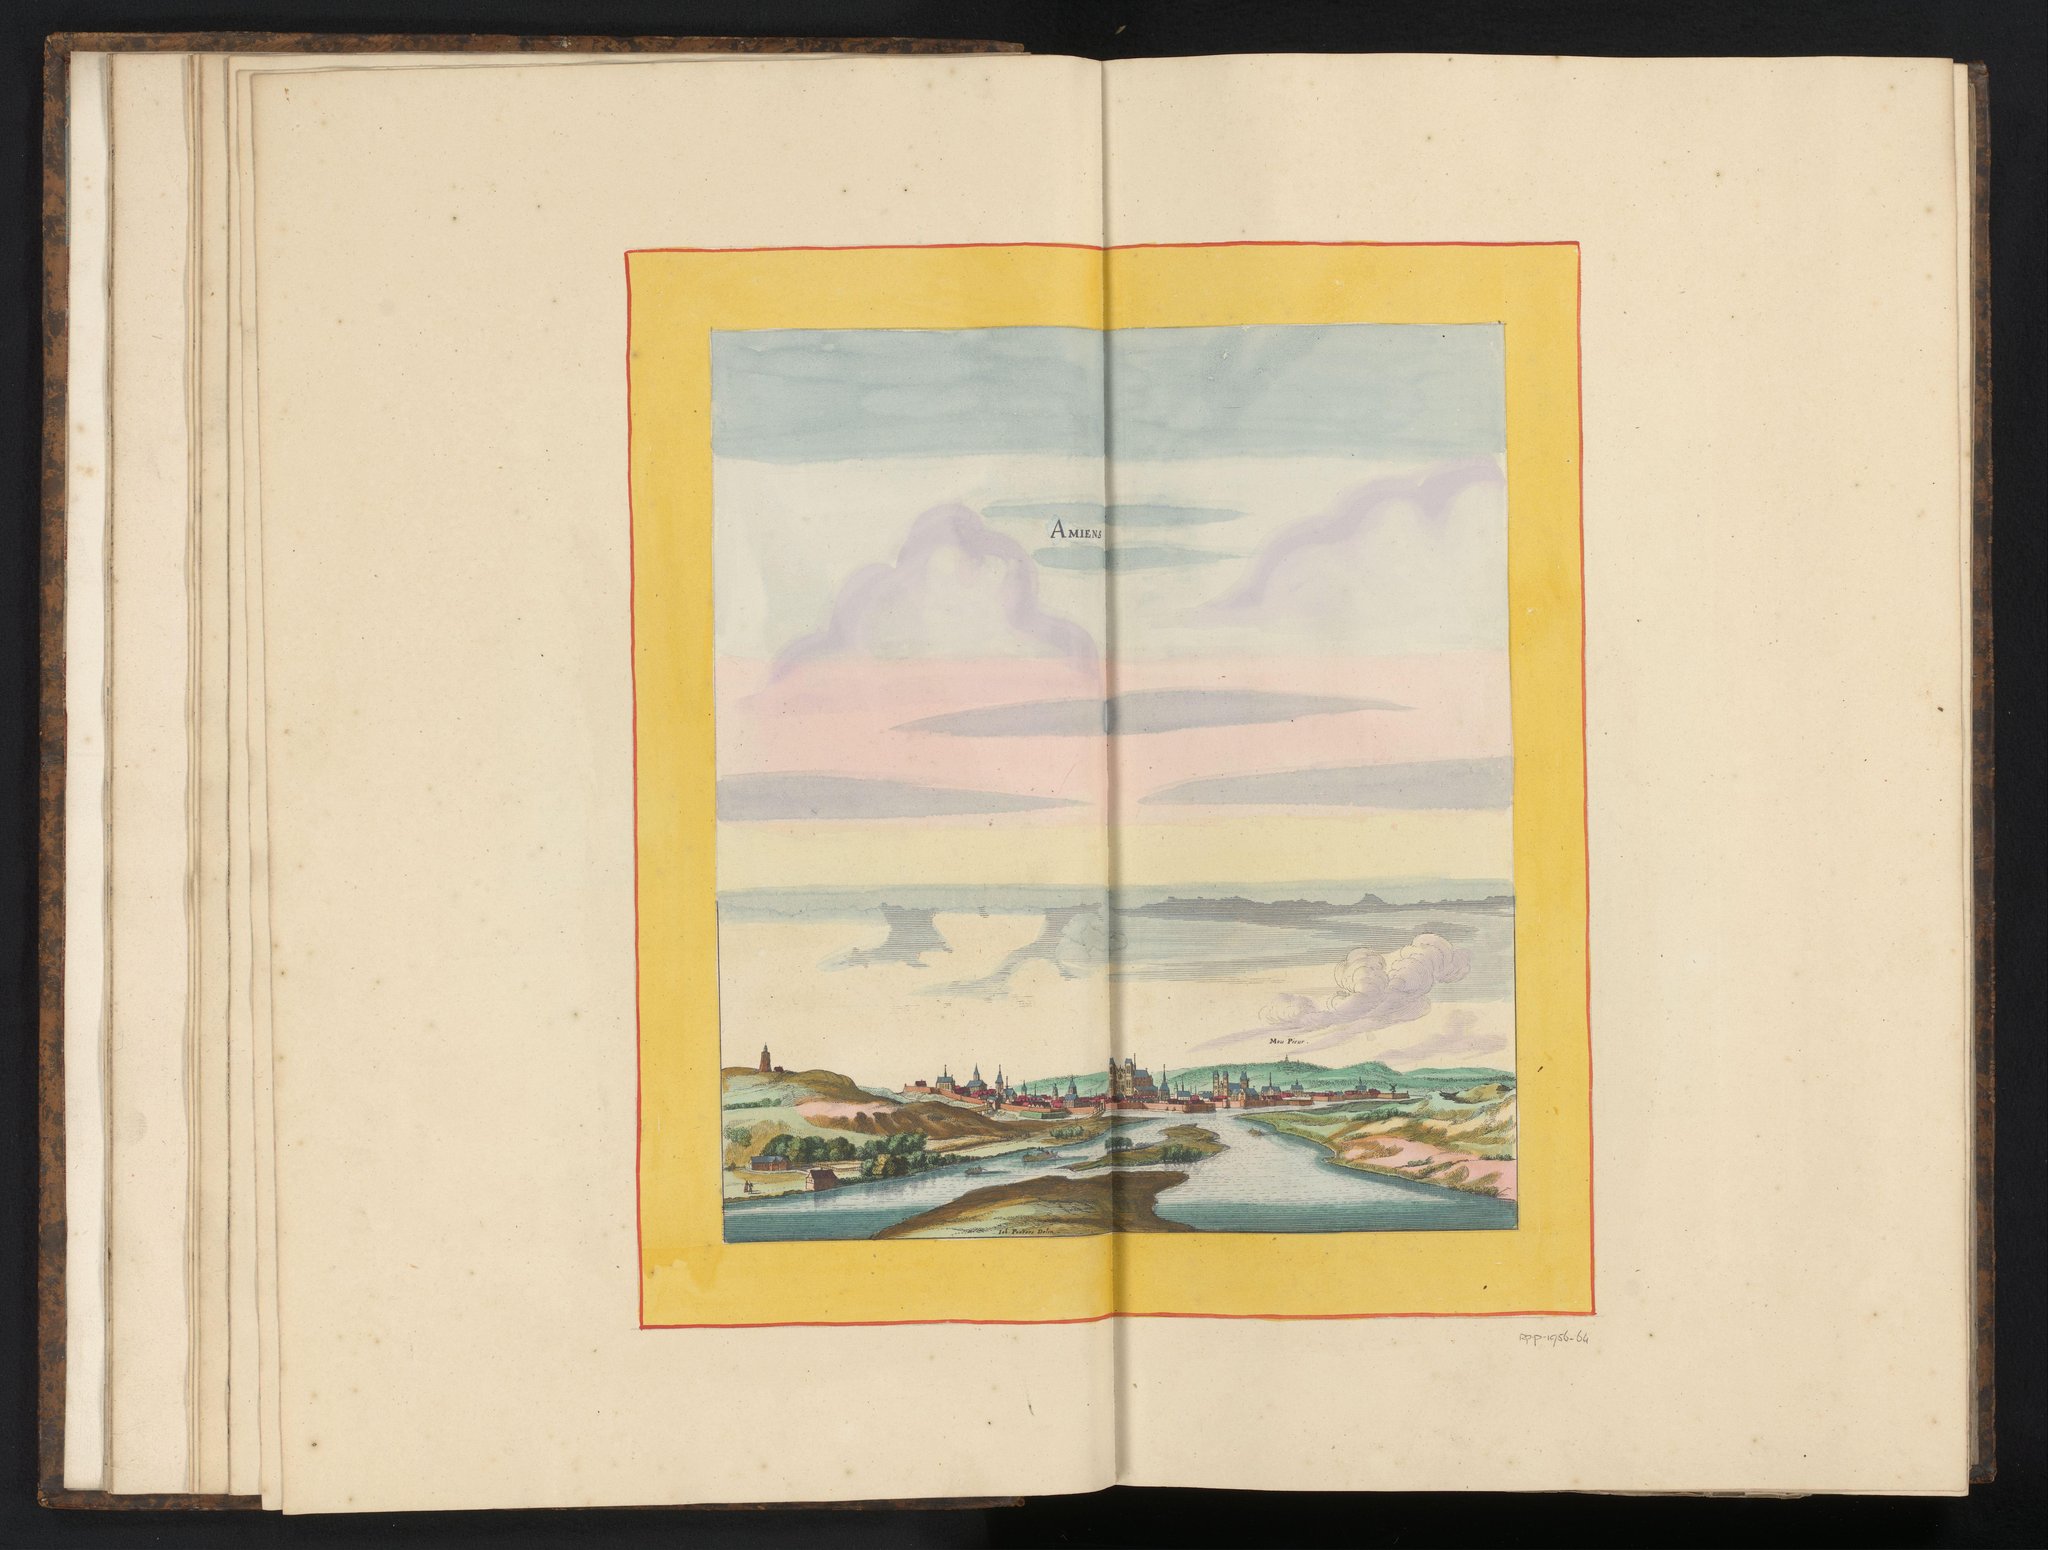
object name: print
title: Gezicht op Amiens in vogelvluchtperspectief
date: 1656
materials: paper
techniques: engraving, etching, hand coloring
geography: frankfurt am main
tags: city-view in general; 'veduta'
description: Prent uit: Zeiller, Martin. Topographia Galliae. 13 dln. Frankfurt: Caspar Merian, 1656, dl. 2, na p. 14. De titel is uit de originele prent gesneden. Boven de gravure is een deel lucht en wolken (bij)geschilderd, waarin de titel gelijmd is. Origineel van één plaat gedrukt met RP-P-1956-59 (Abbeville).